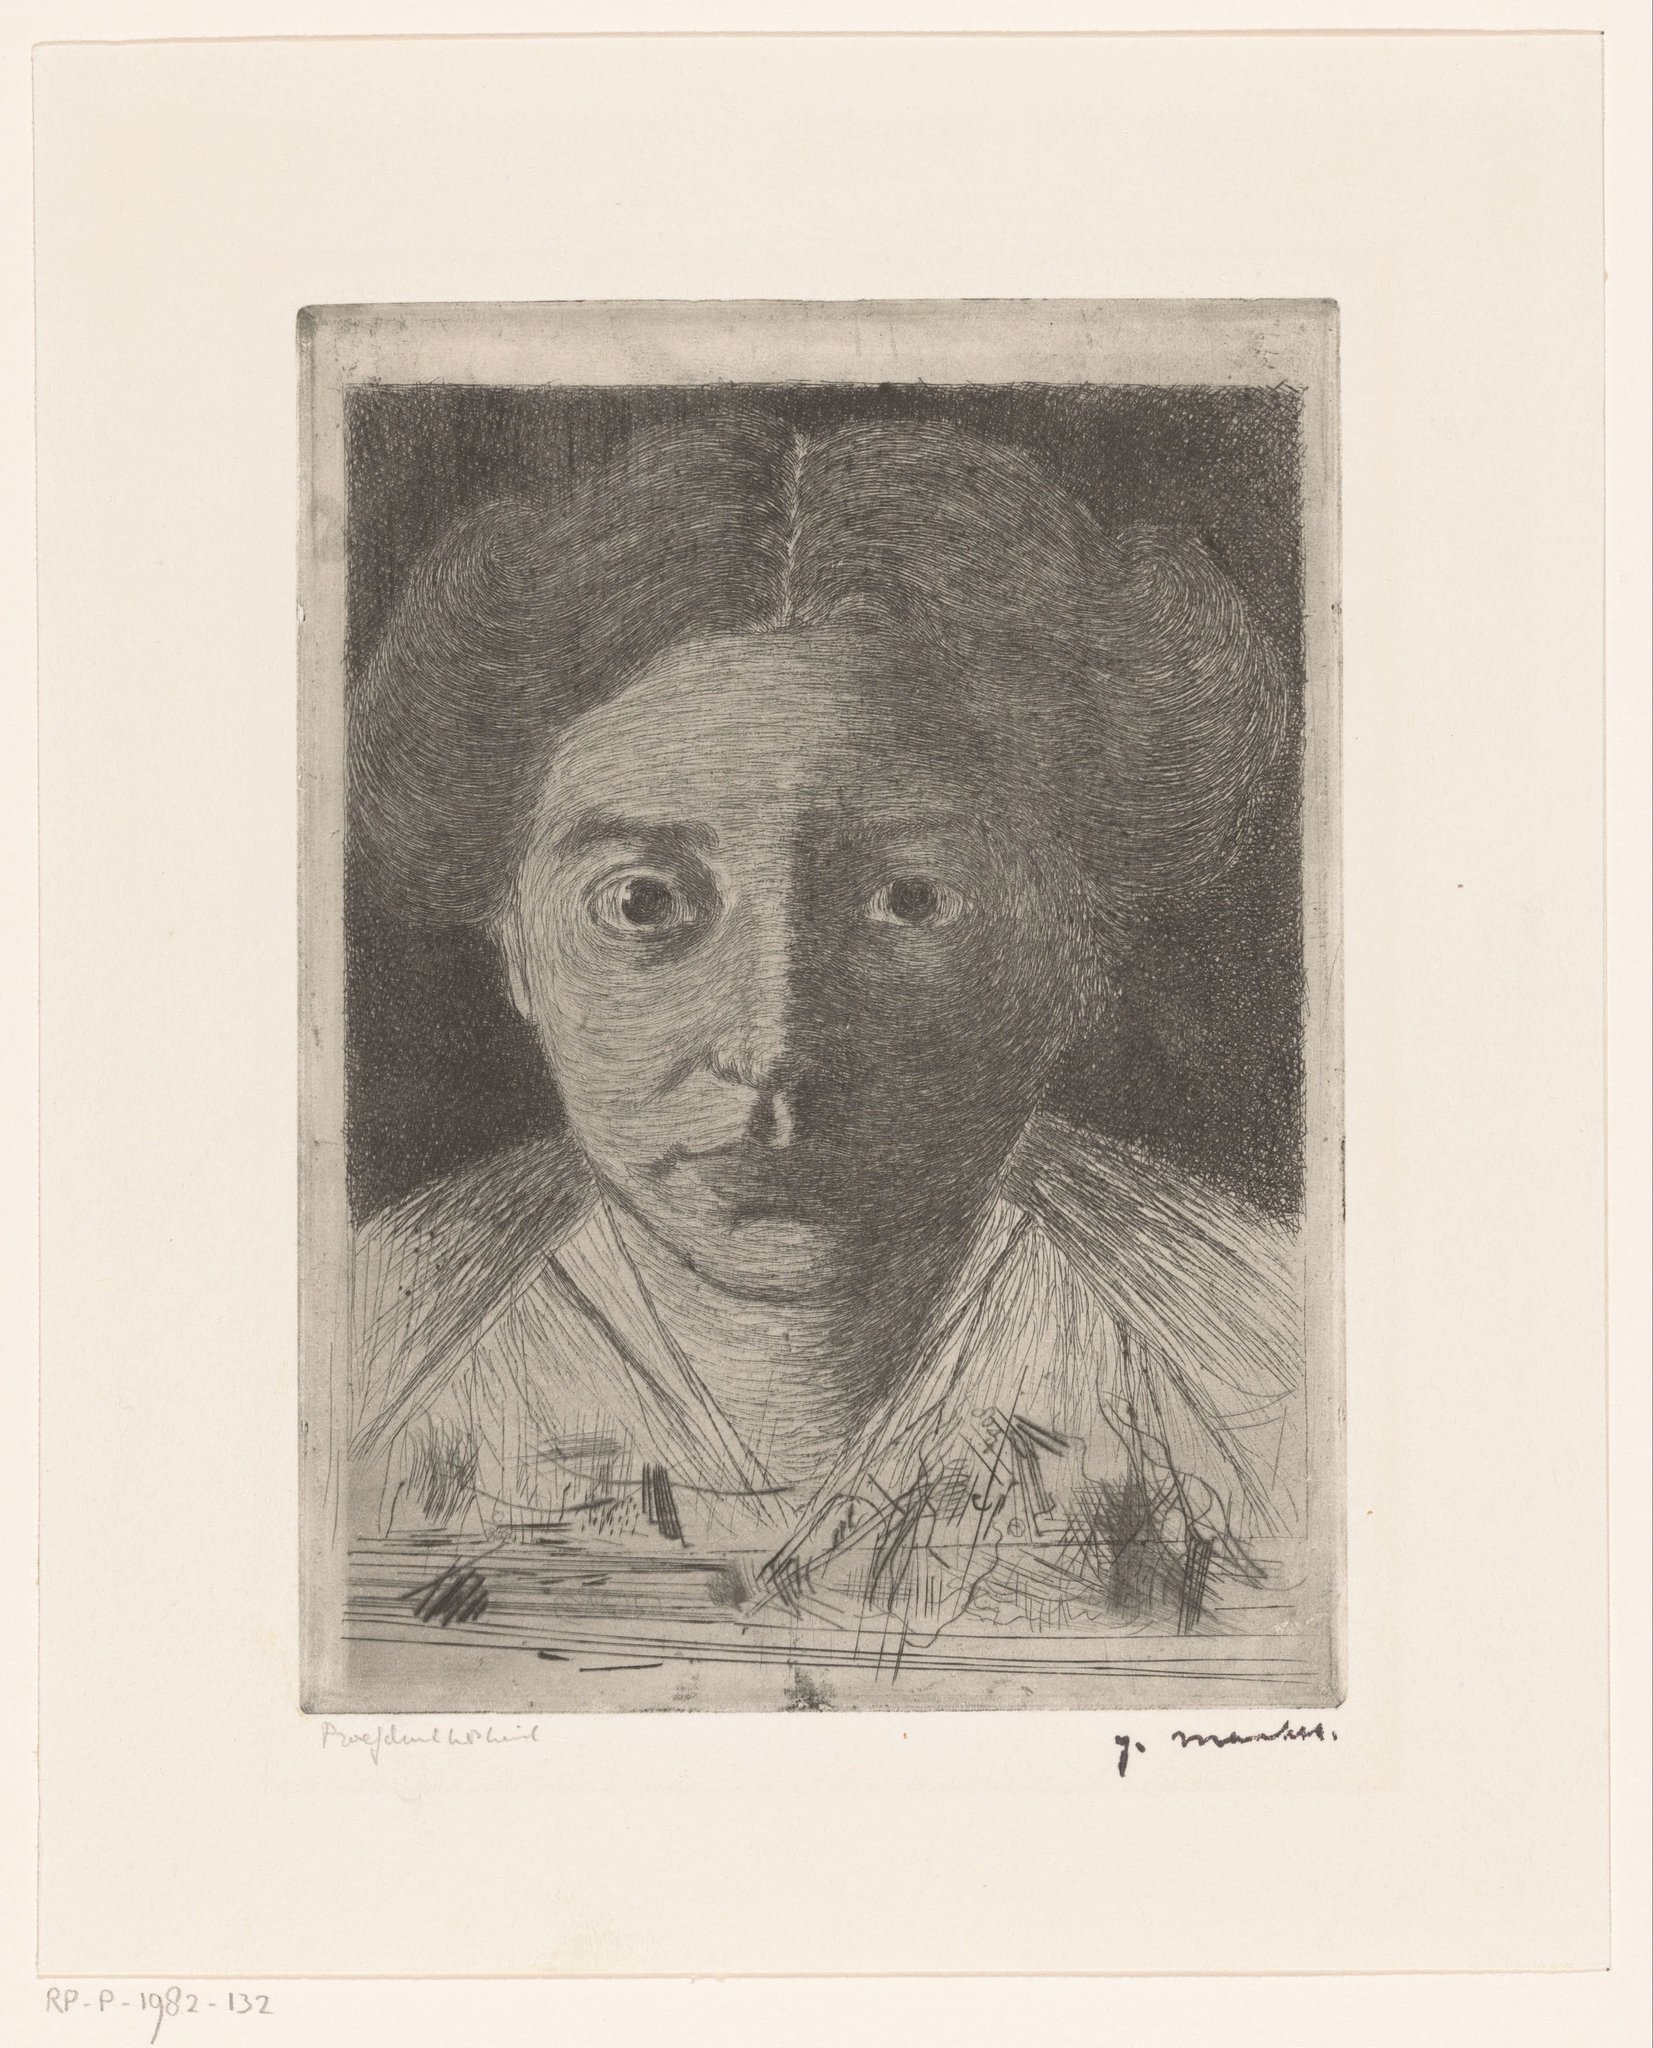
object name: print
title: Portret van Anne Zernike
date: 1914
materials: paper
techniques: etching, intaglio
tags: amsterdam, anne mankes-zernike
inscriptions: collector's mark: Lugt 2228, collector's mark: Lugt 2760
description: In 1968 vervaardigde Kuik op verzoek van de familie Mankes in beperkte oplage nadrukken van houtblokken van Mankes.